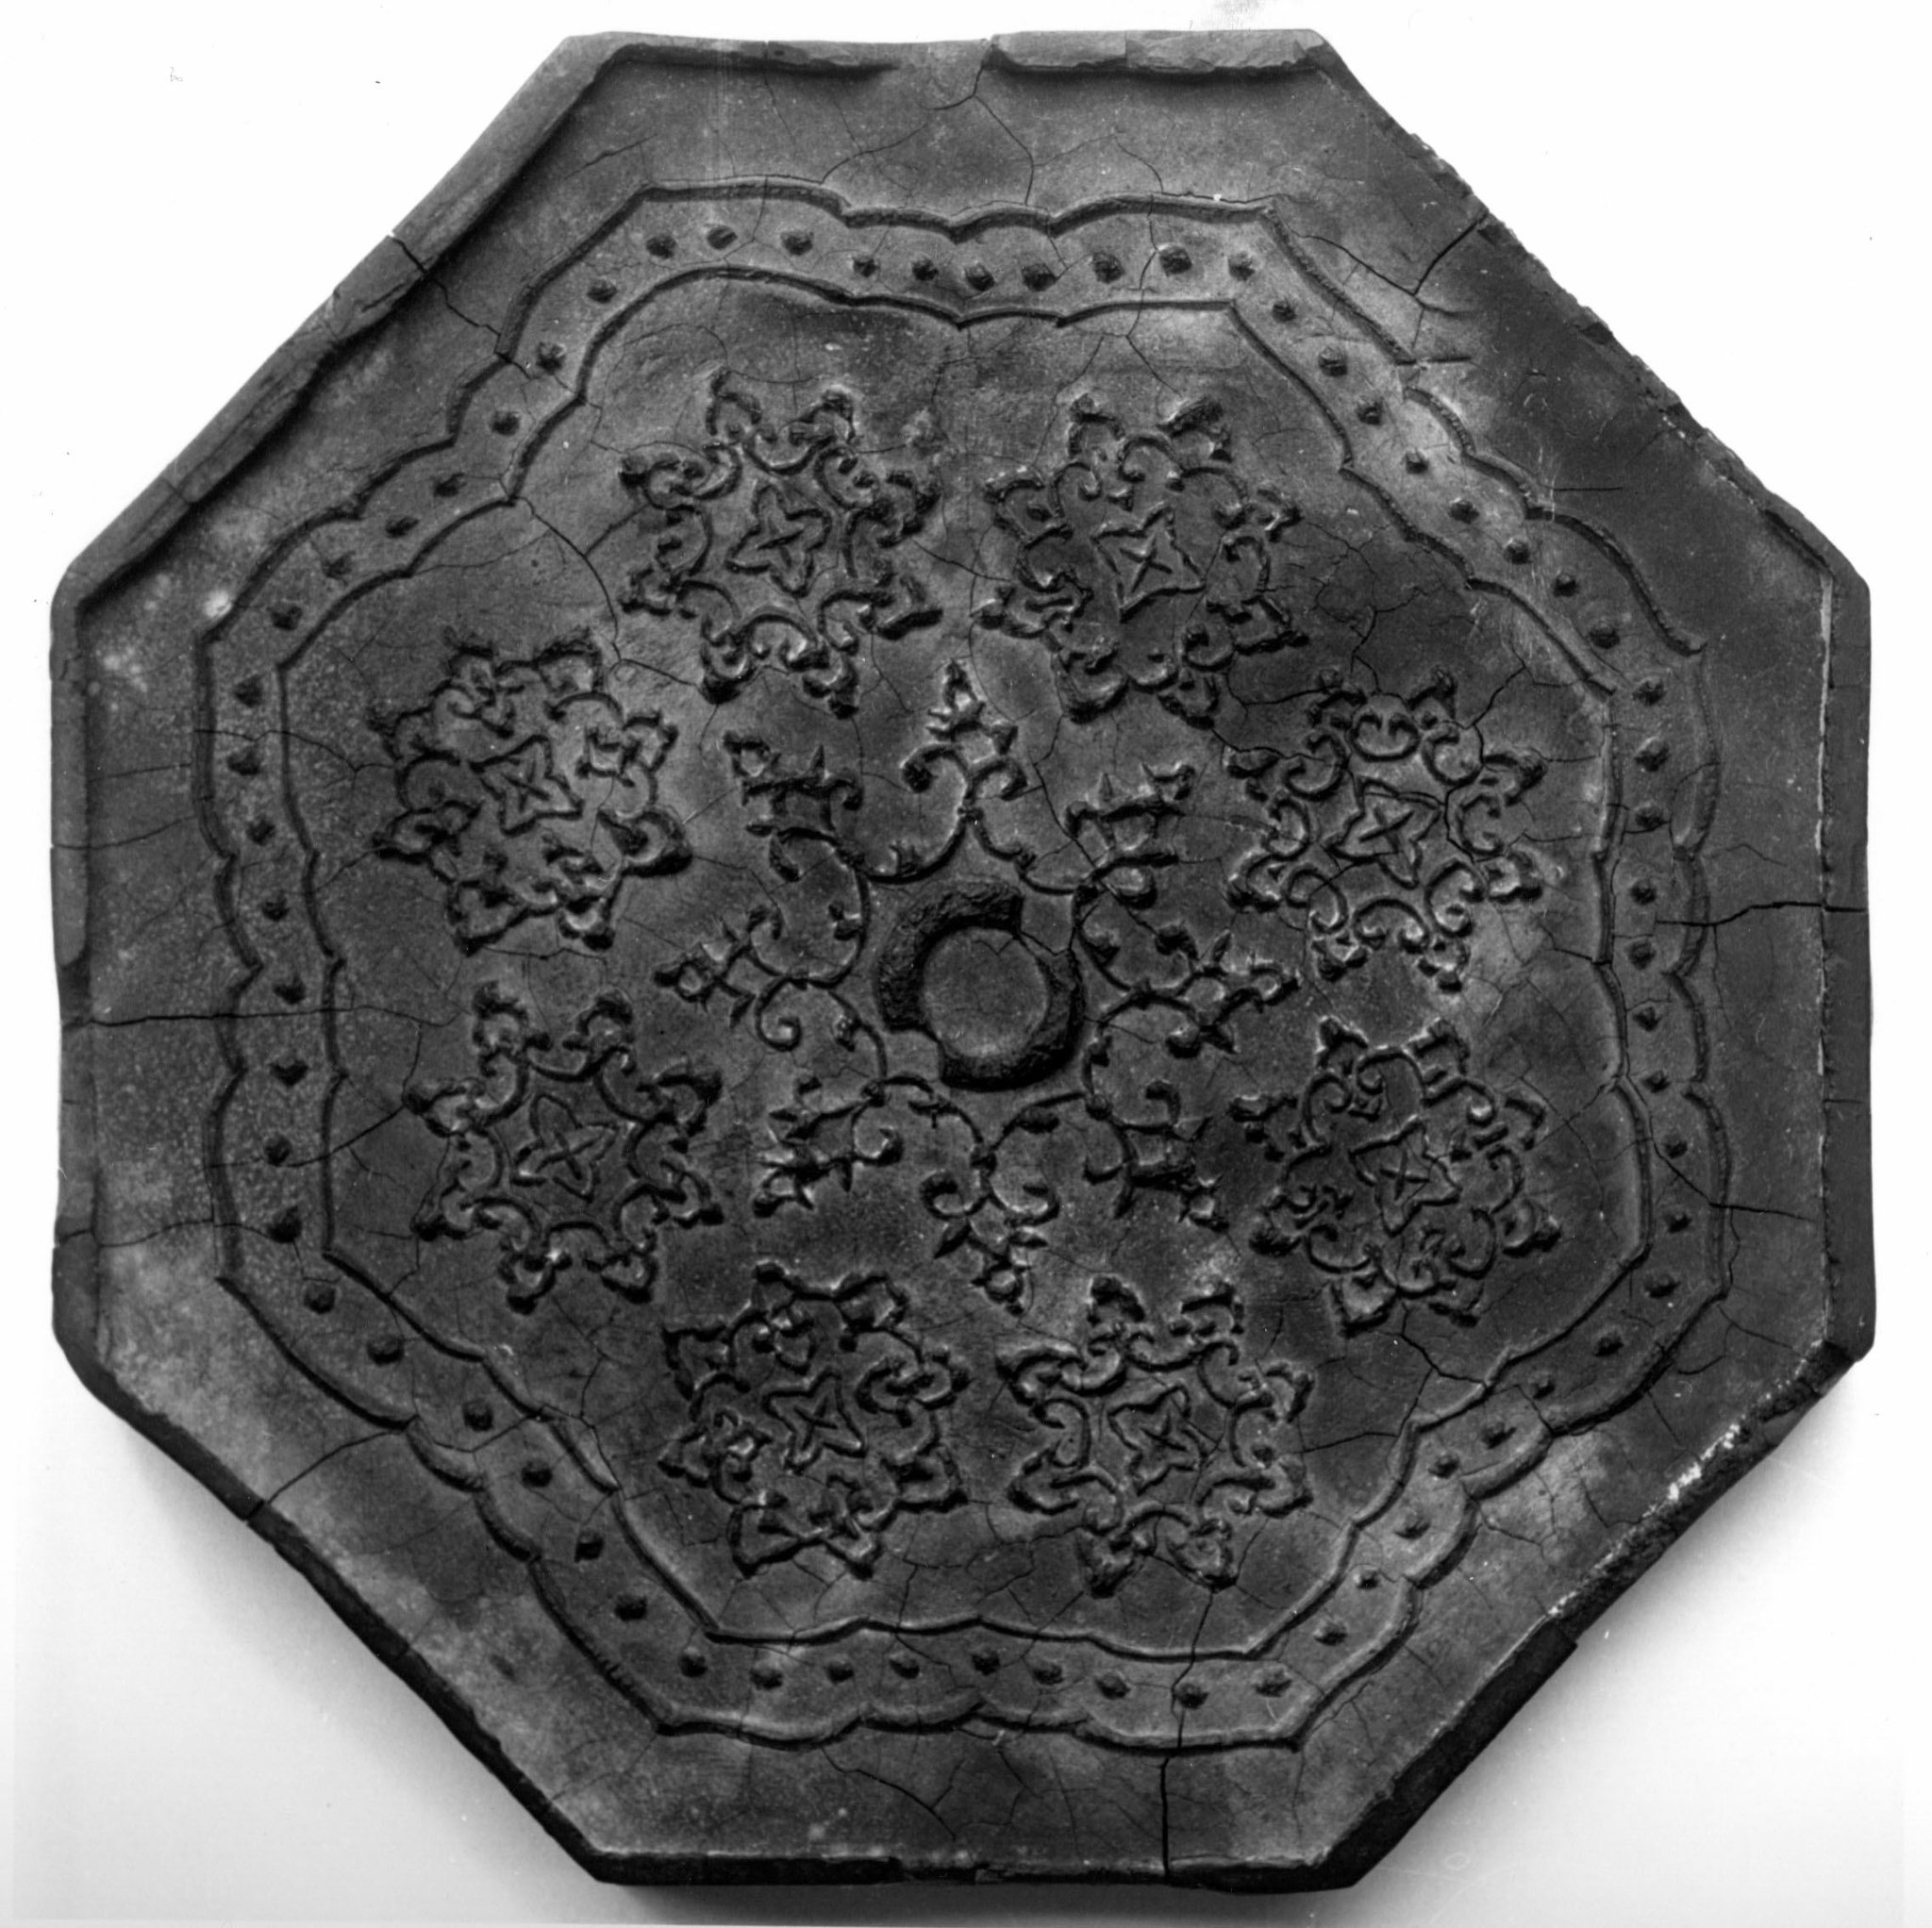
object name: ink tablet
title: Ink Tablet with Tang Mirror Design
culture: chinese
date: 1867-1933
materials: ink